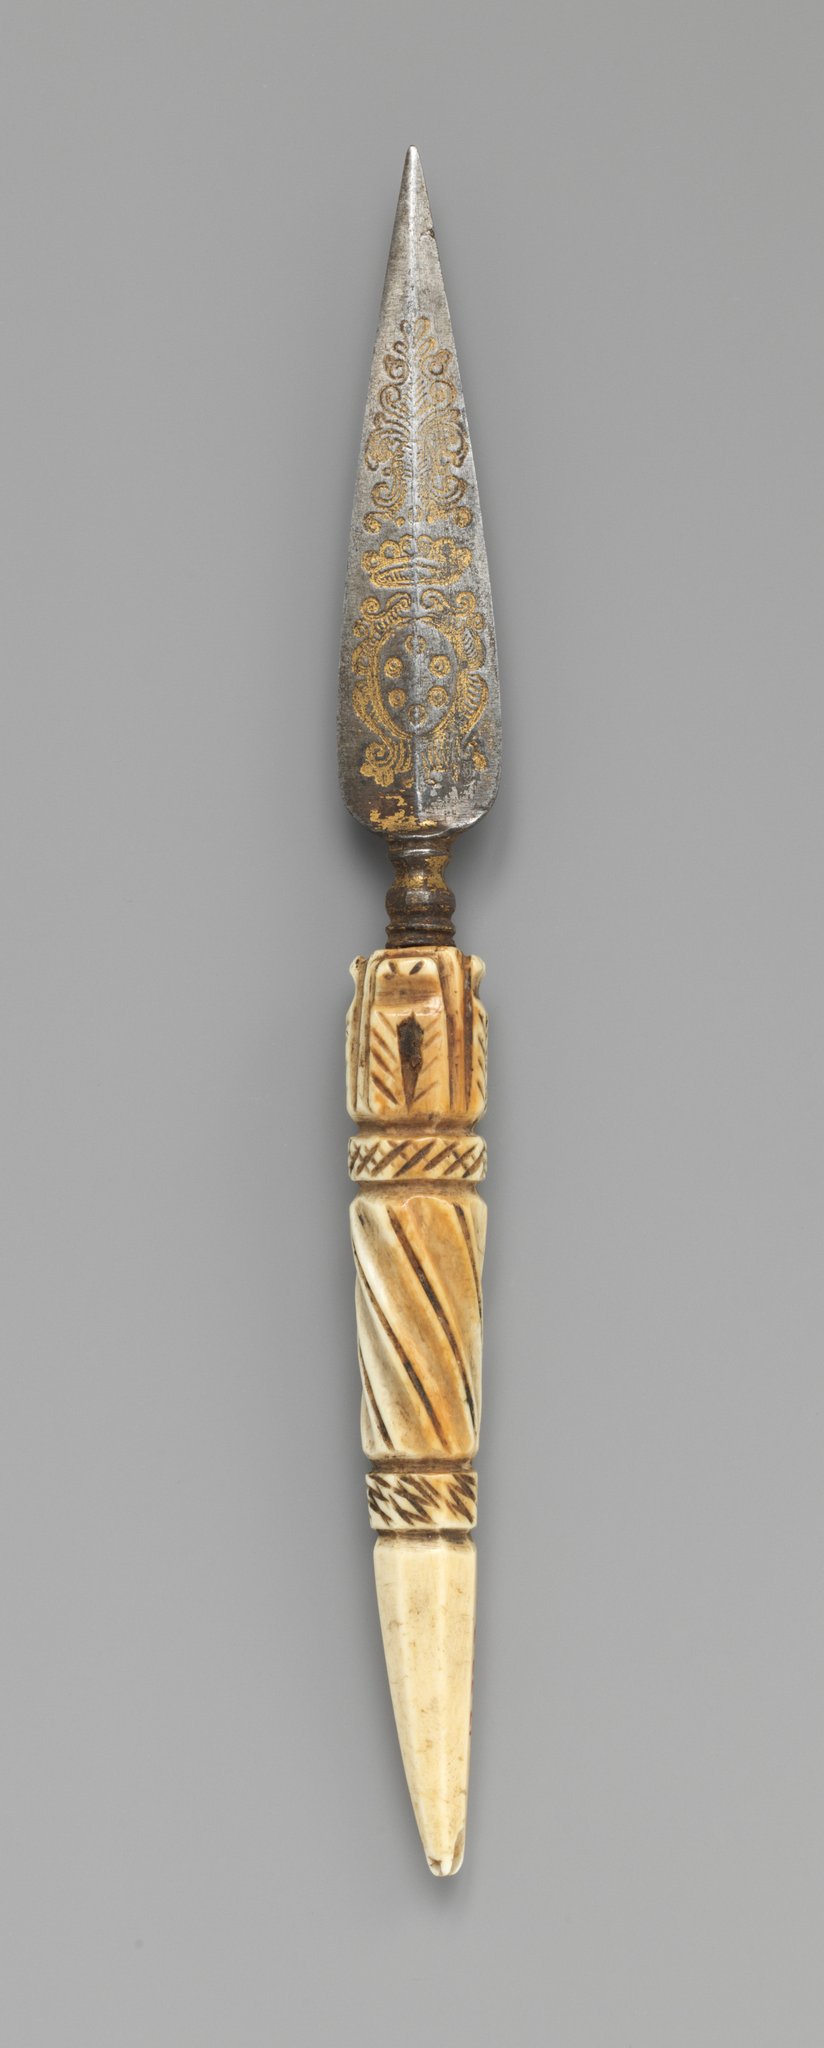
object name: paper cutter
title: Paper cutter with the arms of the Medici family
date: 1501-1600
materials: ivory, silver gilt